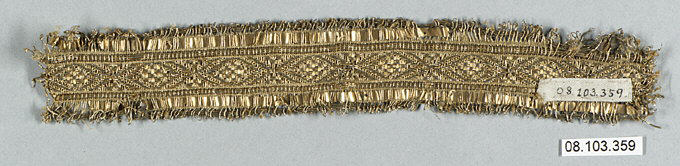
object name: galloon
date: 1601-1800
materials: metal thread